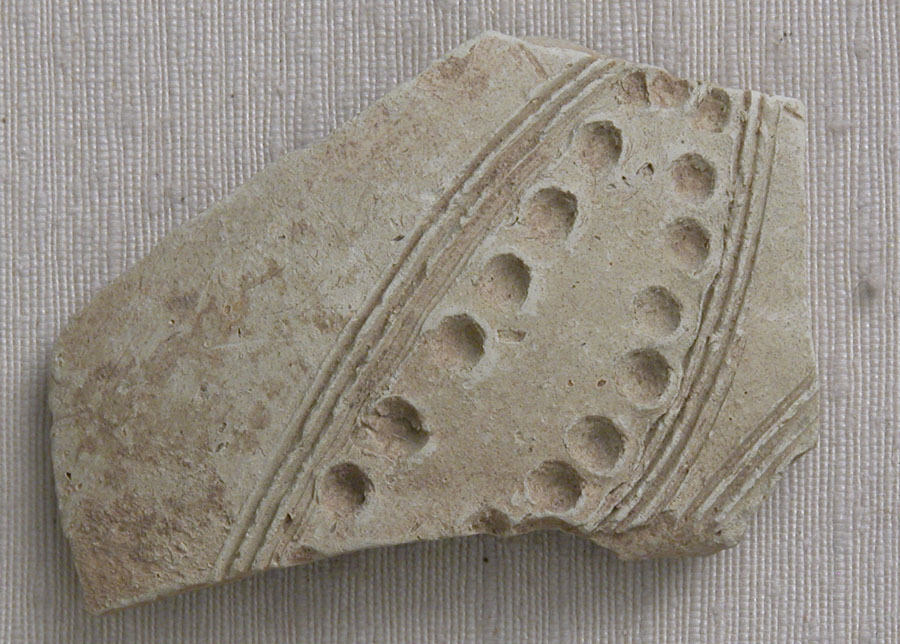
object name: fragment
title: Ceramic Fragment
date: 701-900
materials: earthenware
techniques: incising, stamping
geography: iraq